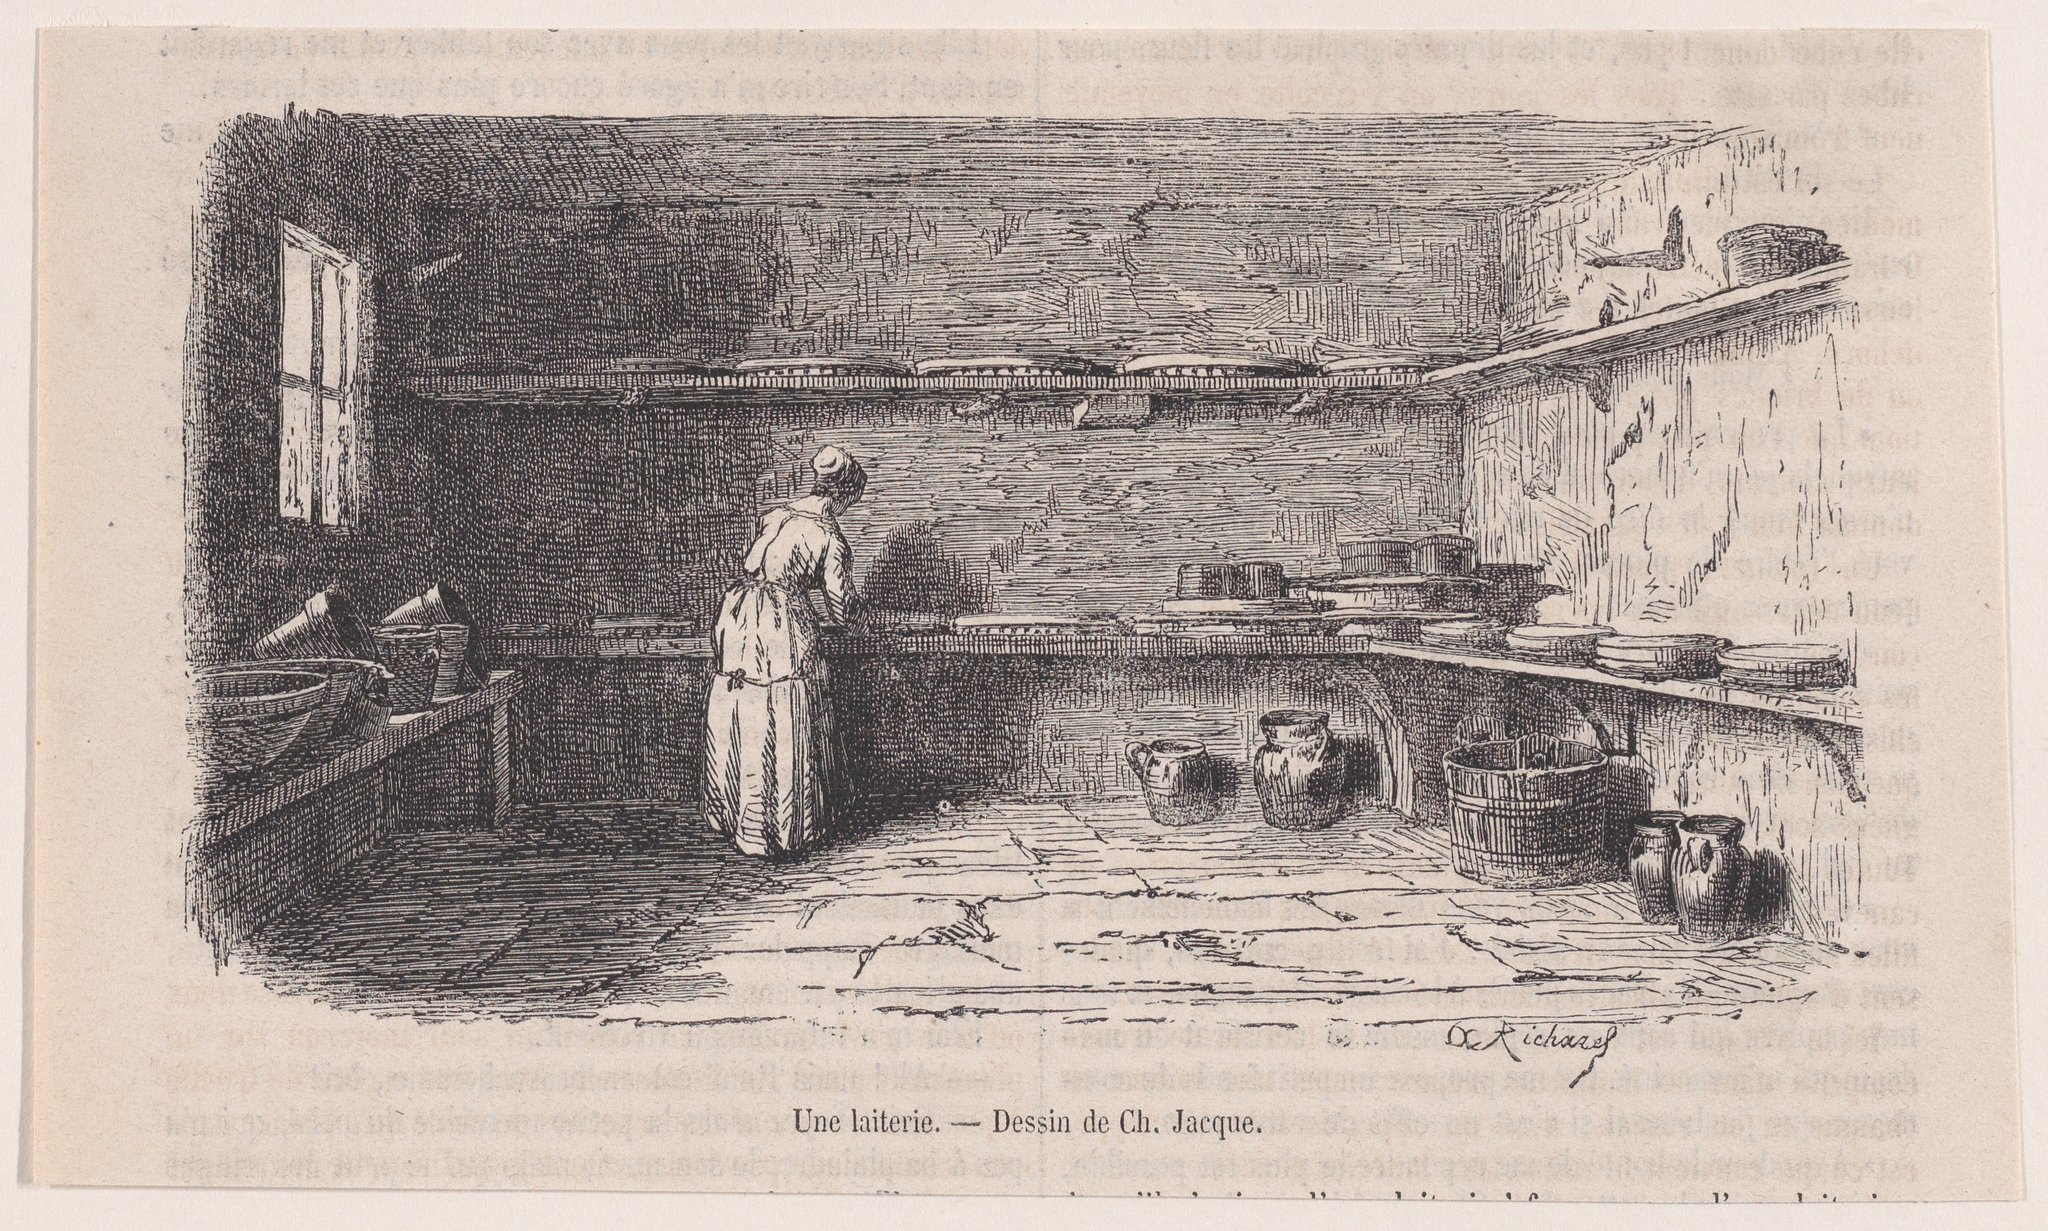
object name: print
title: A Dairy, from "Le Magasin Pittoresque"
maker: charles émile jacque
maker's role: artist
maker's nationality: french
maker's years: 1813-1894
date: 1852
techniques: engraving